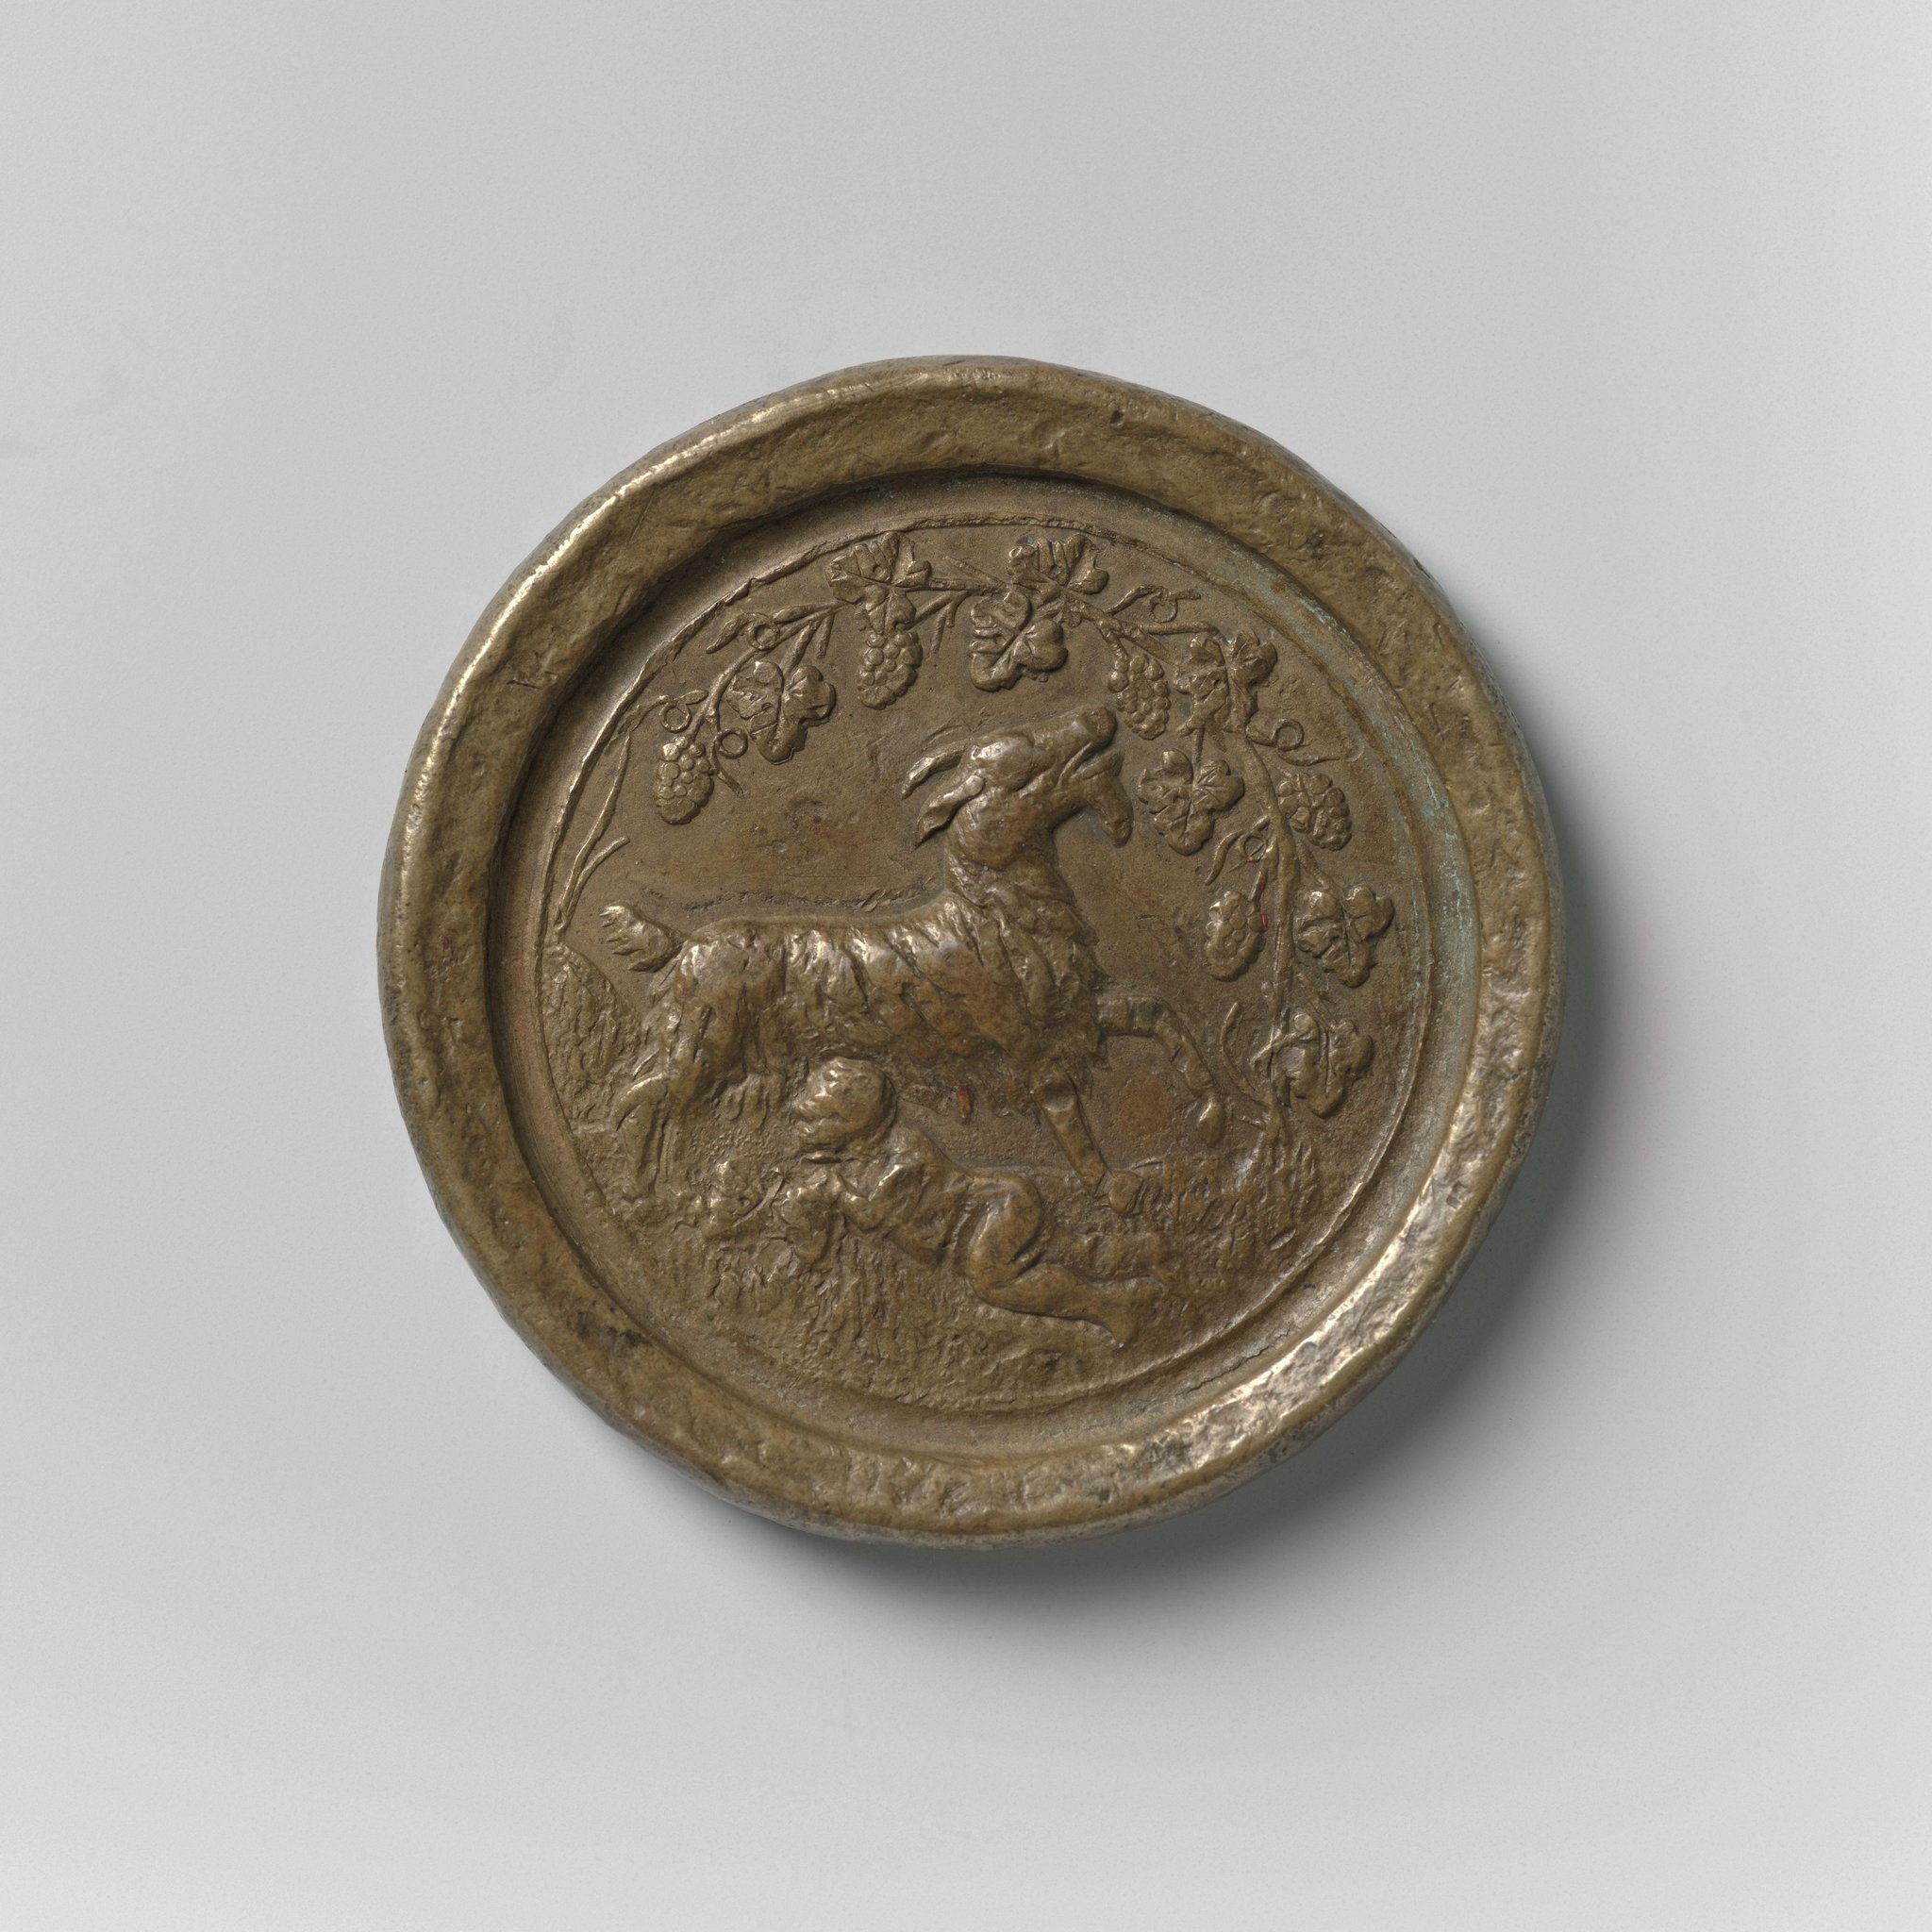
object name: history medal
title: Penning van het wijntappersgilde te 's Gravenhage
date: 1600-1800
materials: brass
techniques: casting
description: Gegoten messing penning, op de voorzijde de jonge Zeus gezoogd door Amalthea, die van wijnranken eet, op de keerzijde een man met fles en glas op een wijnvat, omringd door wijnranken